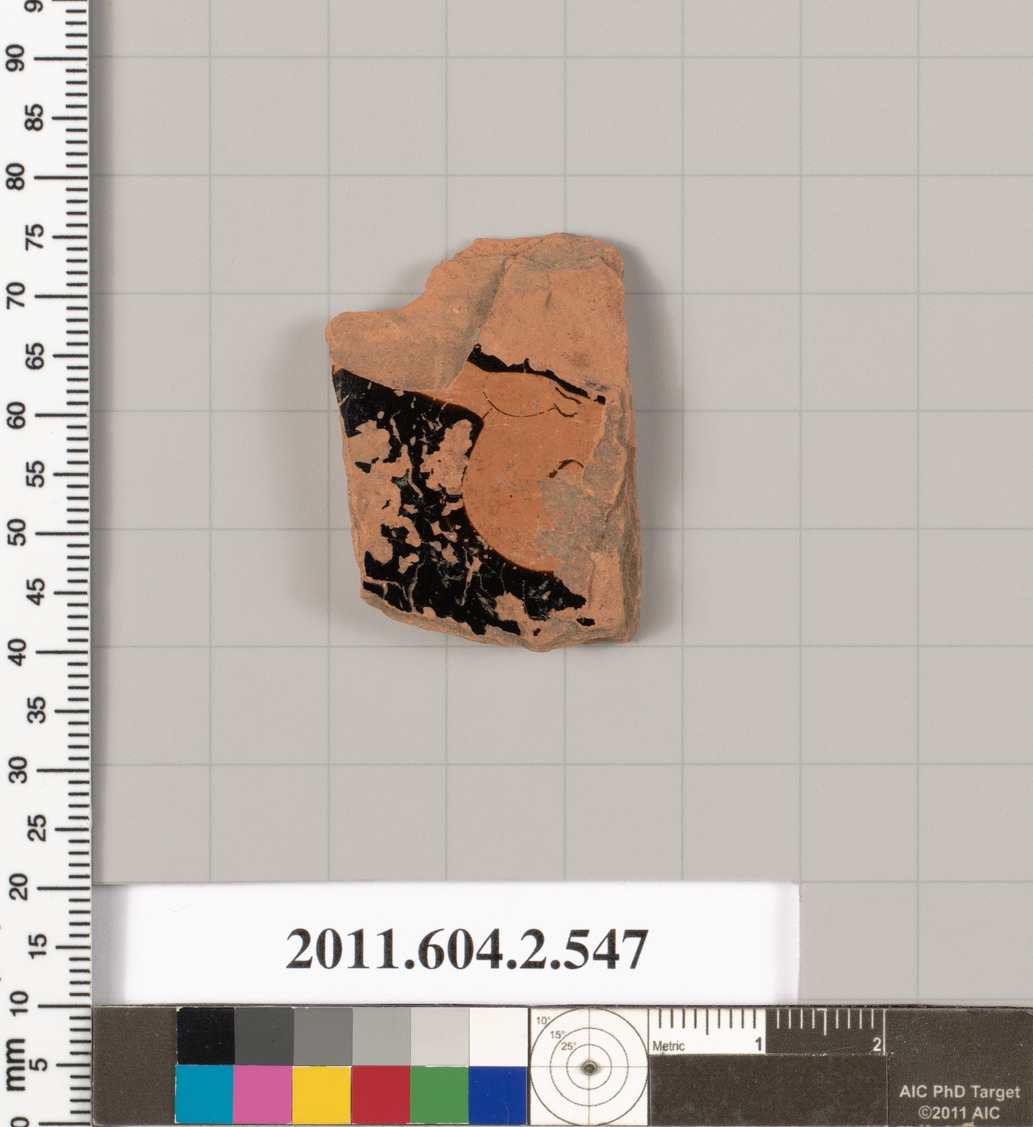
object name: column krater fragment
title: Terracotta fragment of a column-krater (bowl for mixing wine and water)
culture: greek, attic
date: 460-440 BCE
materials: terracotta